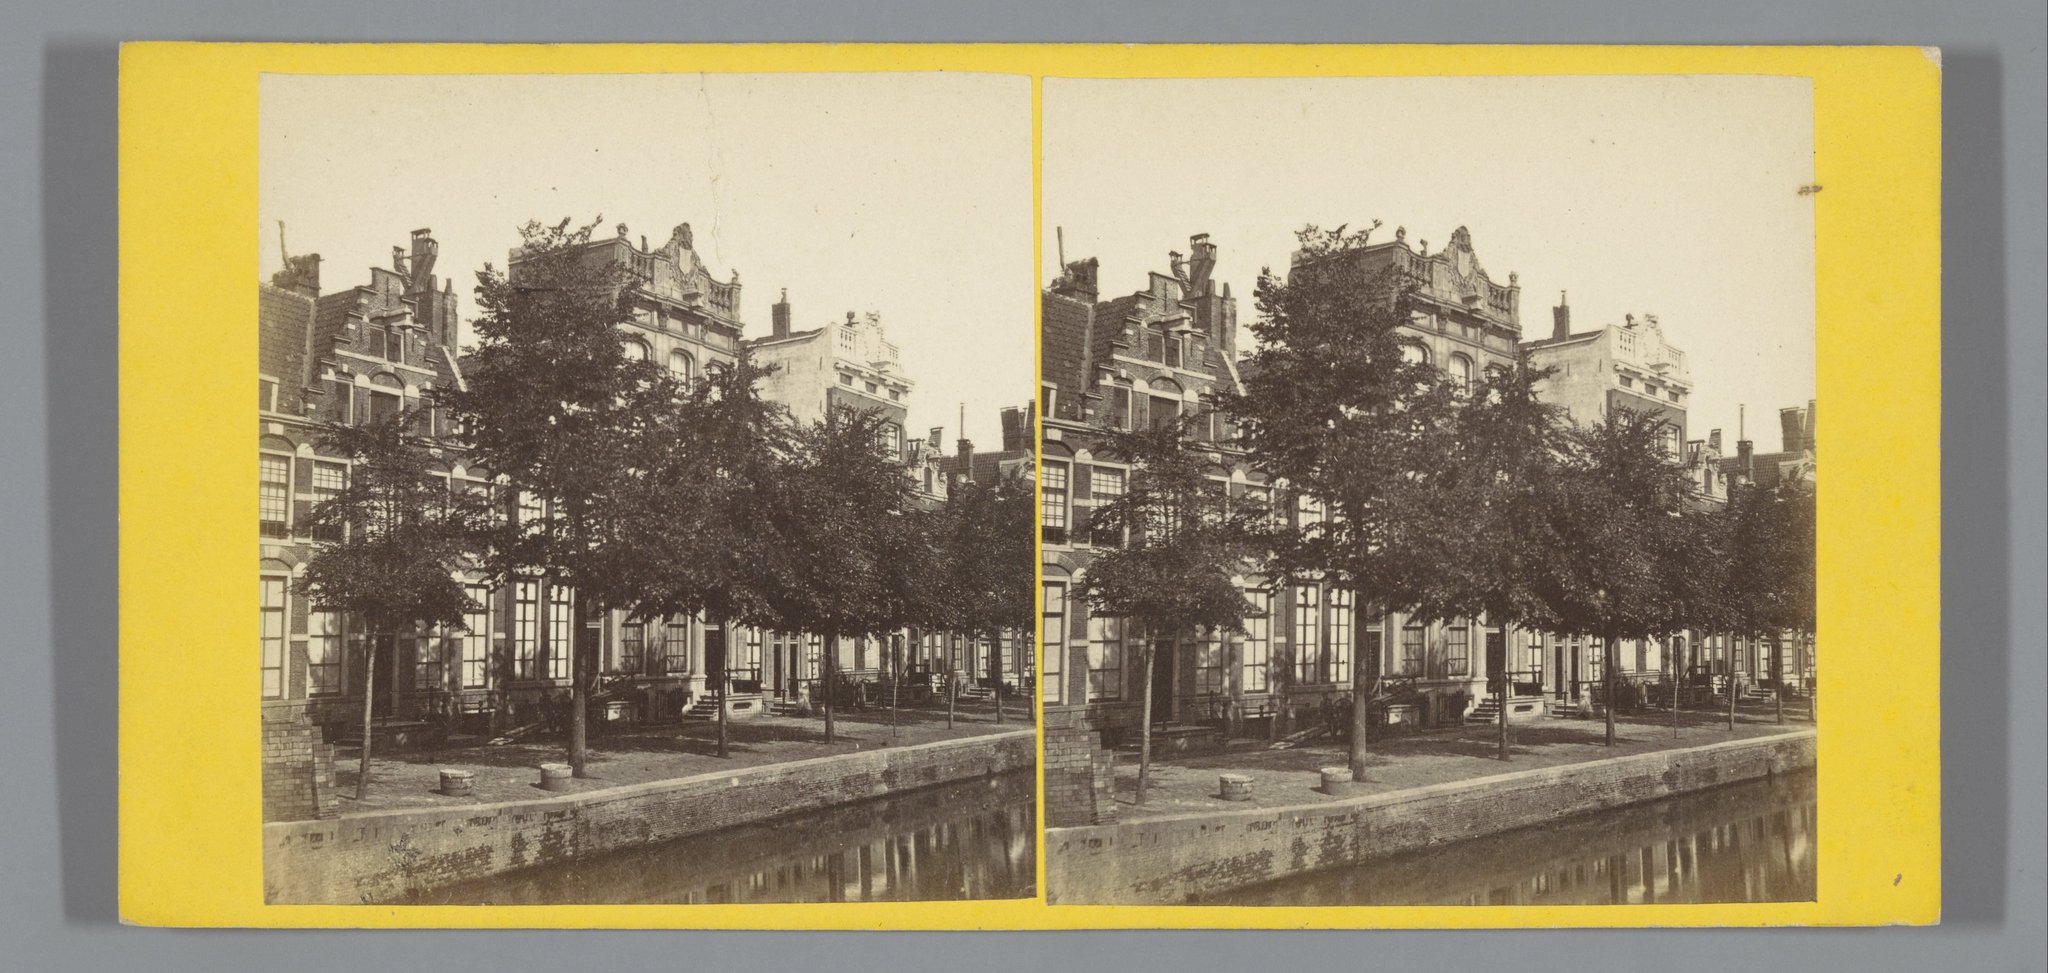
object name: stereograph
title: Gezicht op de Herengracht bij de Huidenstraat in Amsterdam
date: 1860-1885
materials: cardboard, photographic support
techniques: albumen print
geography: amsterdam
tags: street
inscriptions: inscription: ‘De Heerengracht bij de Huidenstraat.’